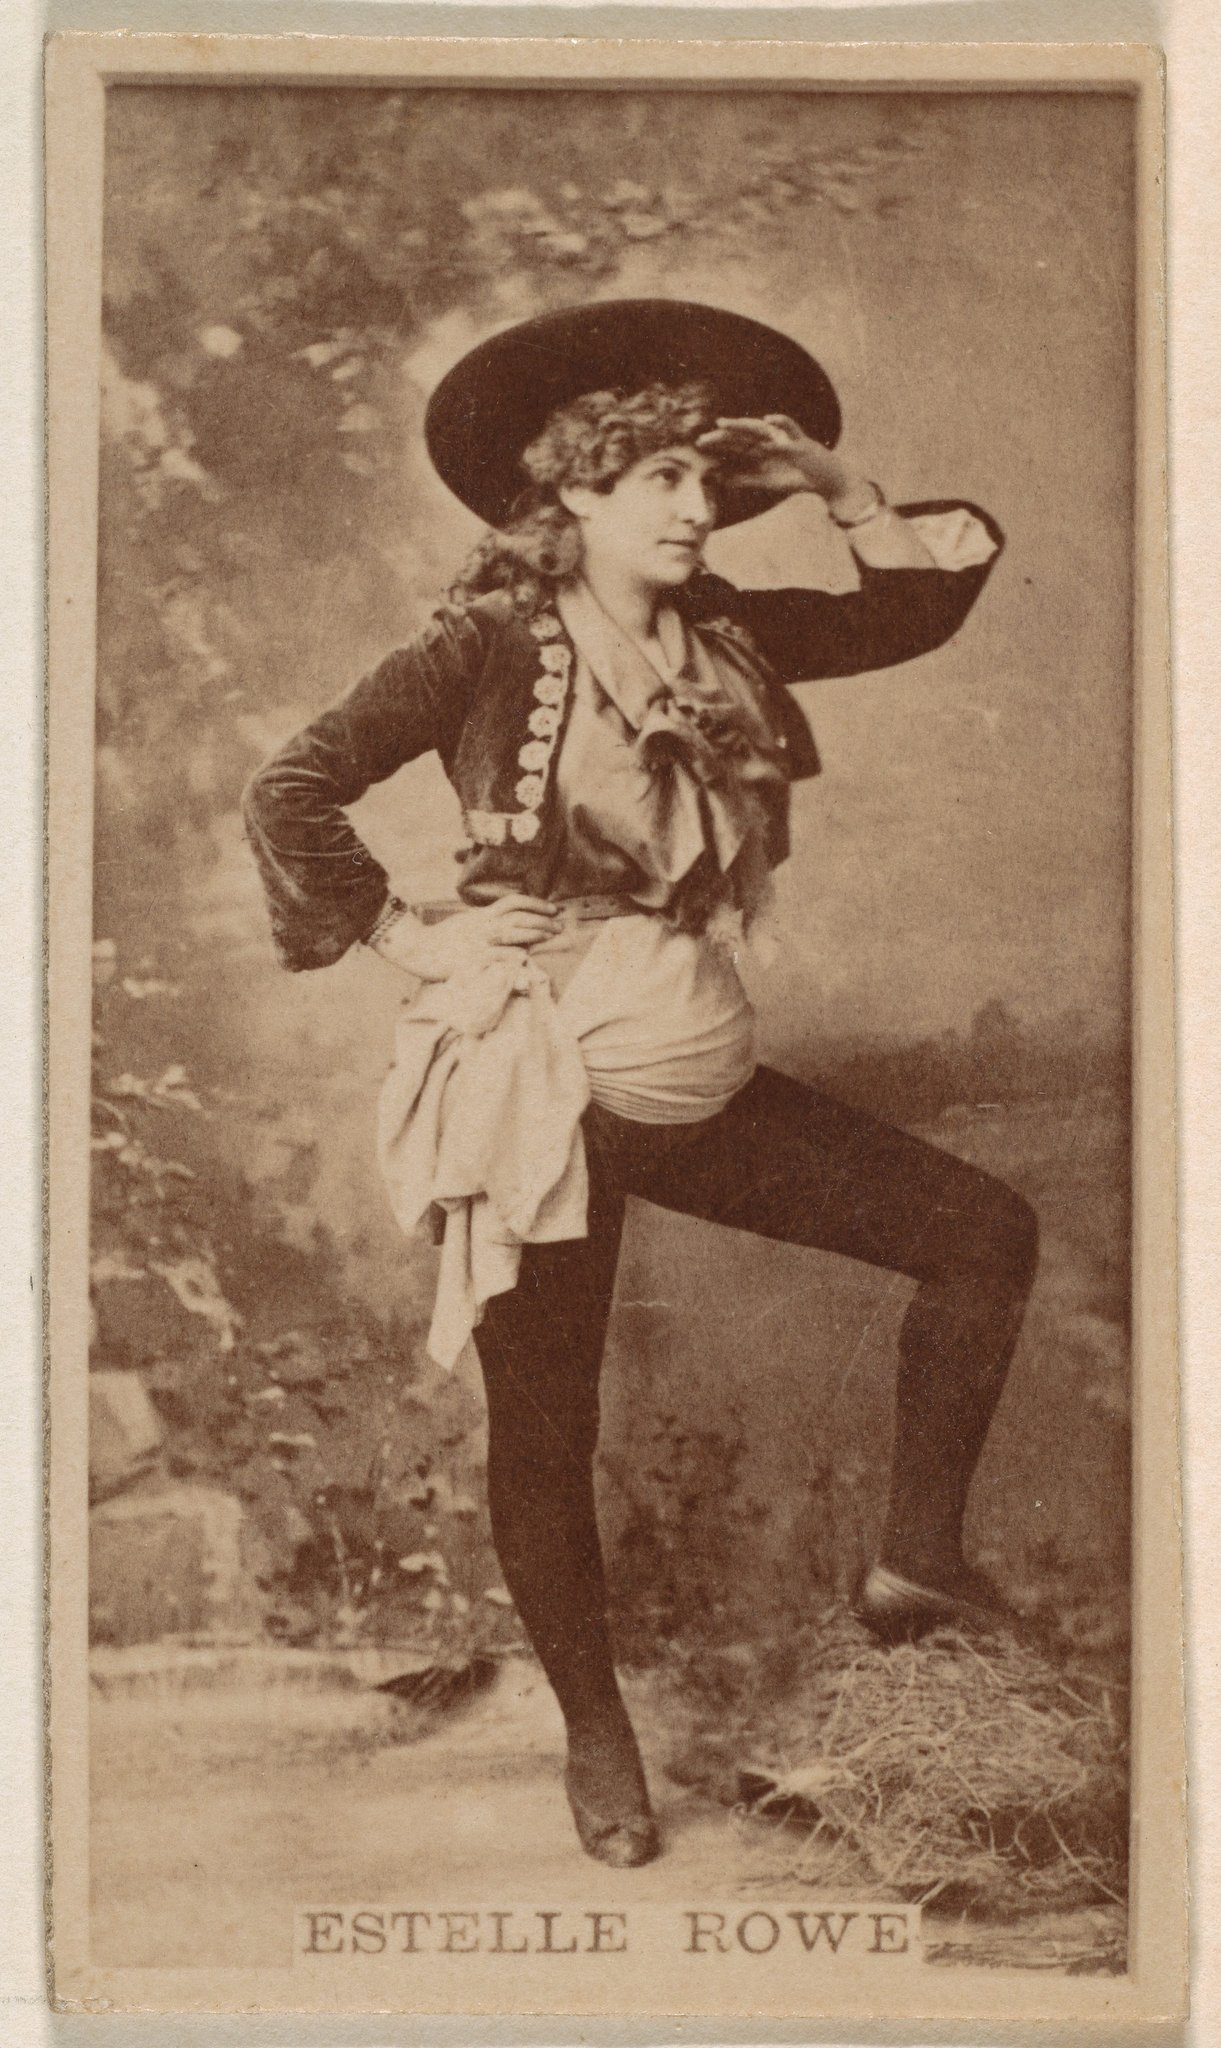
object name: photograph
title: Estelle Rowe, from the Actresses series (N245) issued by Kinney Brothers to promote Sweet Caporal Cigarettes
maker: kinney brothers tobacco company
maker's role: publisher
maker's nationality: american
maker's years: 1869-2011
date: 1890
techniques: albumen silver print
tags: portraits,women,actresses